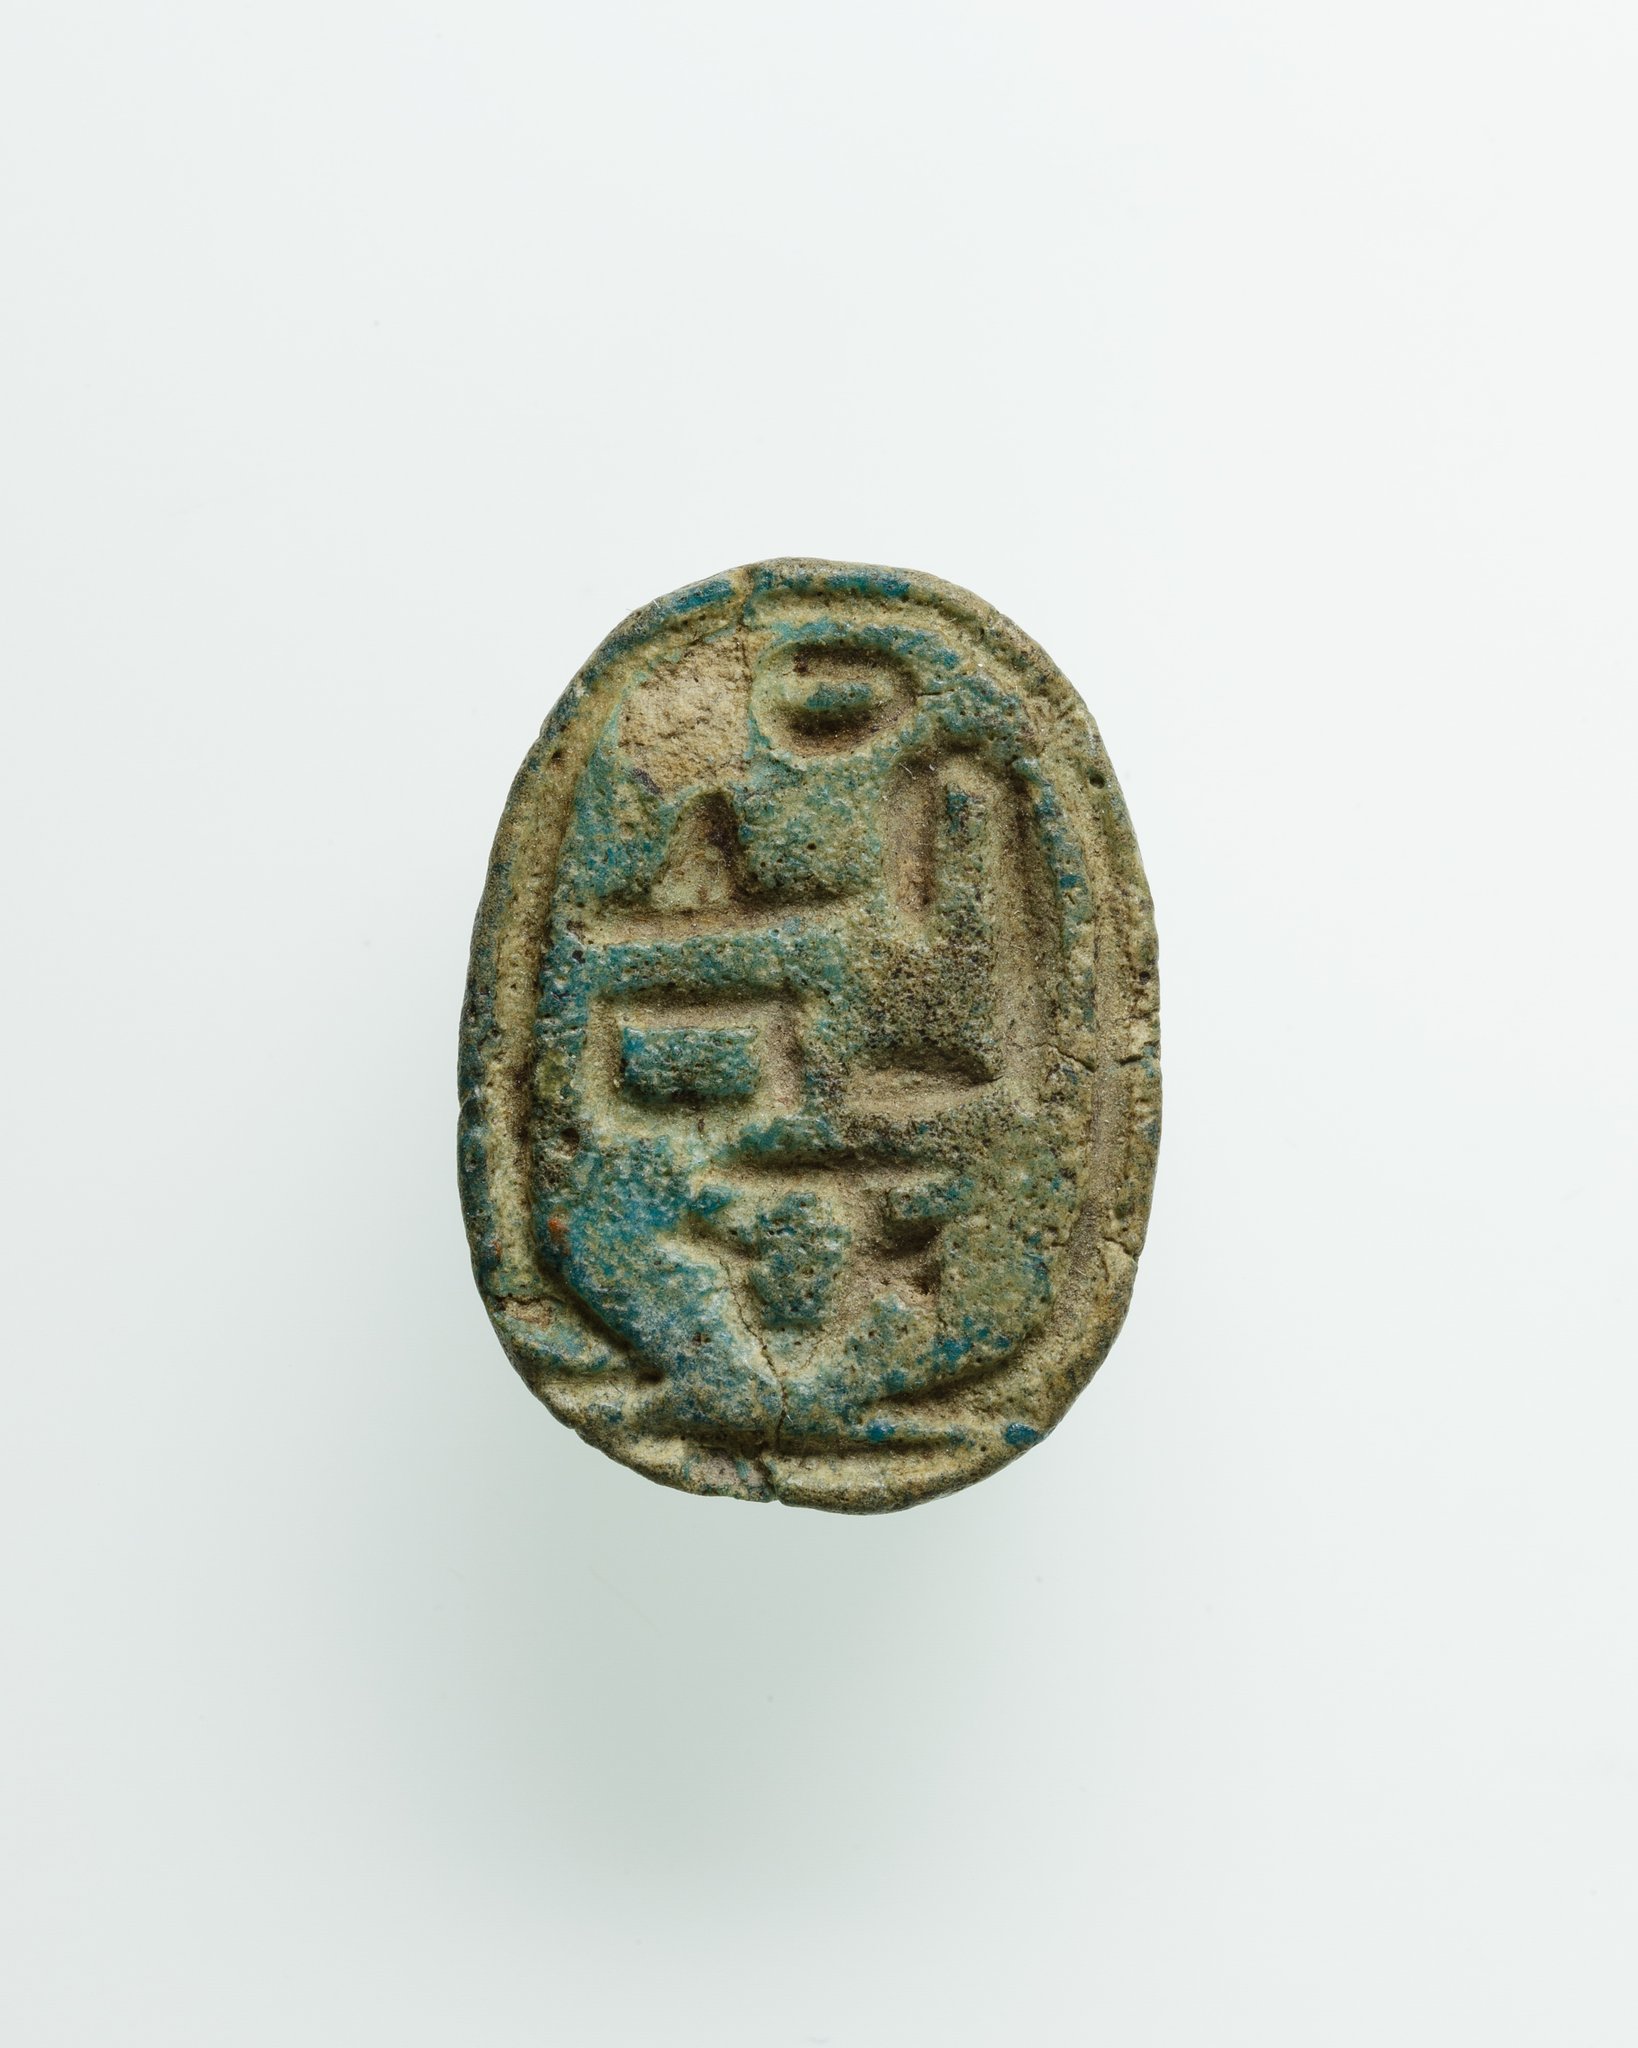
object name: scarab, sehetepibre, amenemhat i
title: Scarab Inscribed with the Name Sehetepibre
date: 1570-1550 BCE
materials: faience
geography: egypt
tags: hieroglyphs,scarabs